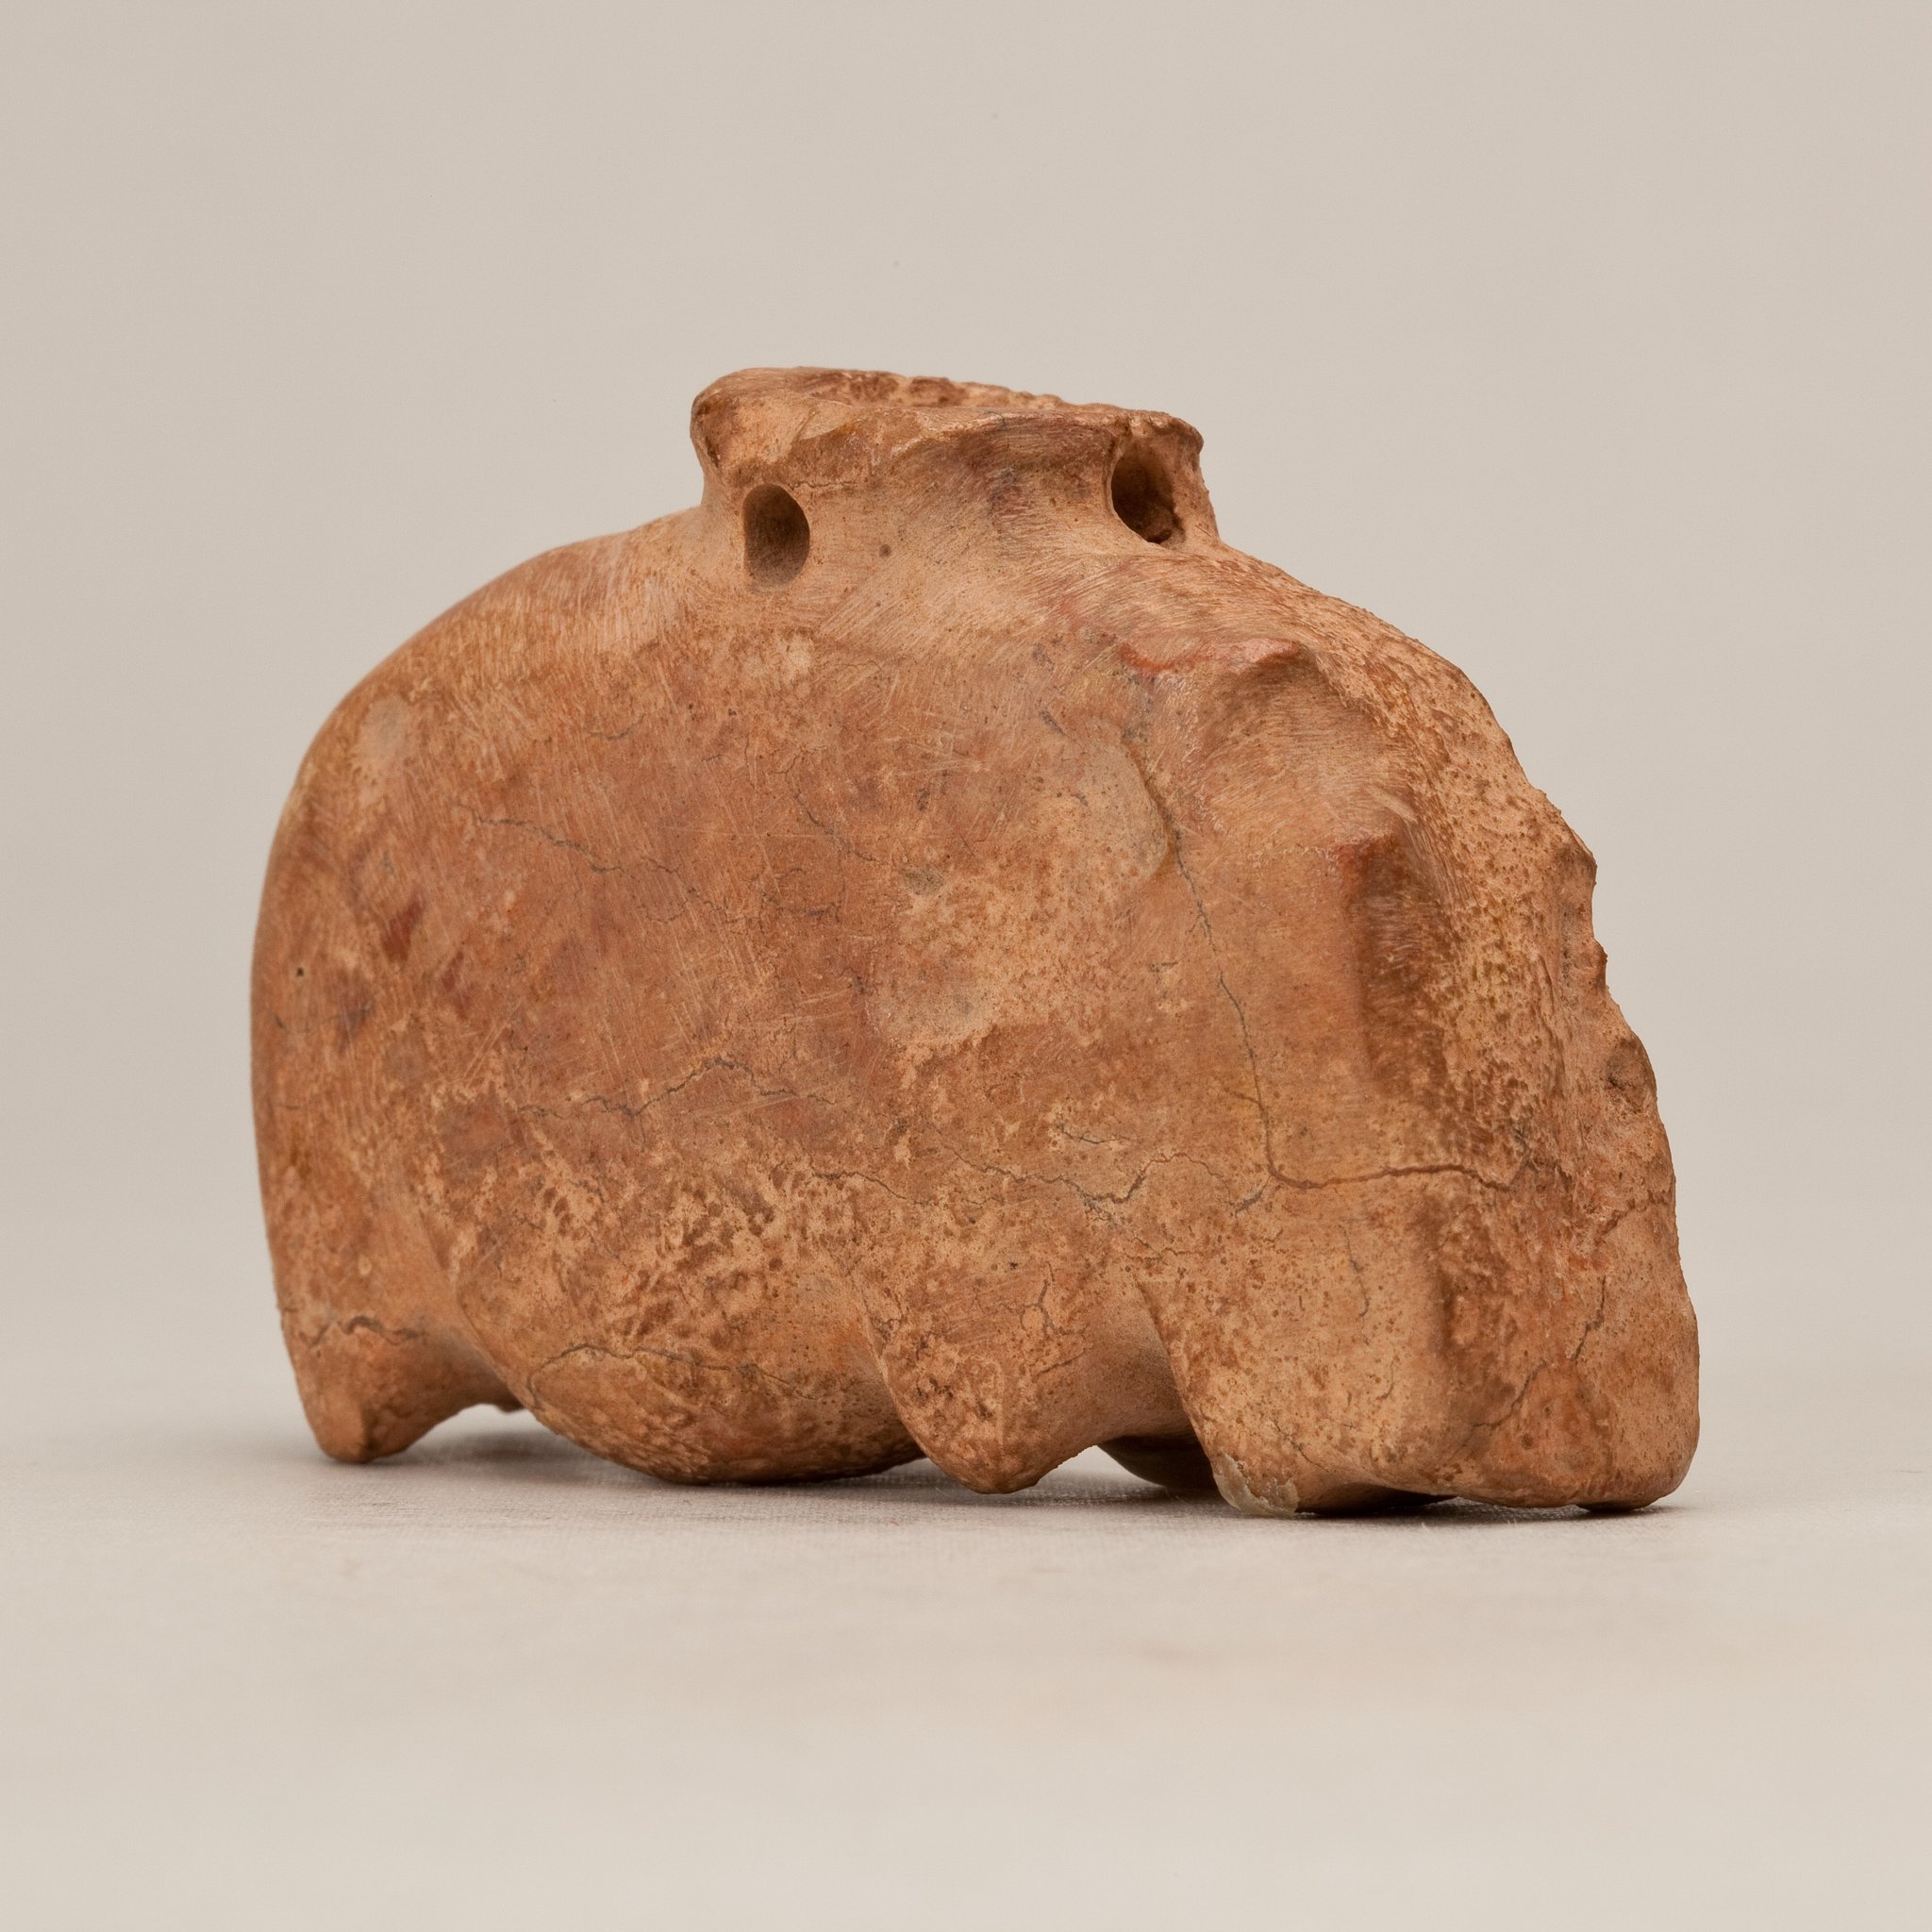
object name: amulet, hippopotamus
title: Hippopotamus amulet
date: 4500-4000 BCE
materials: limestone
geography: egypt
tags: hippos